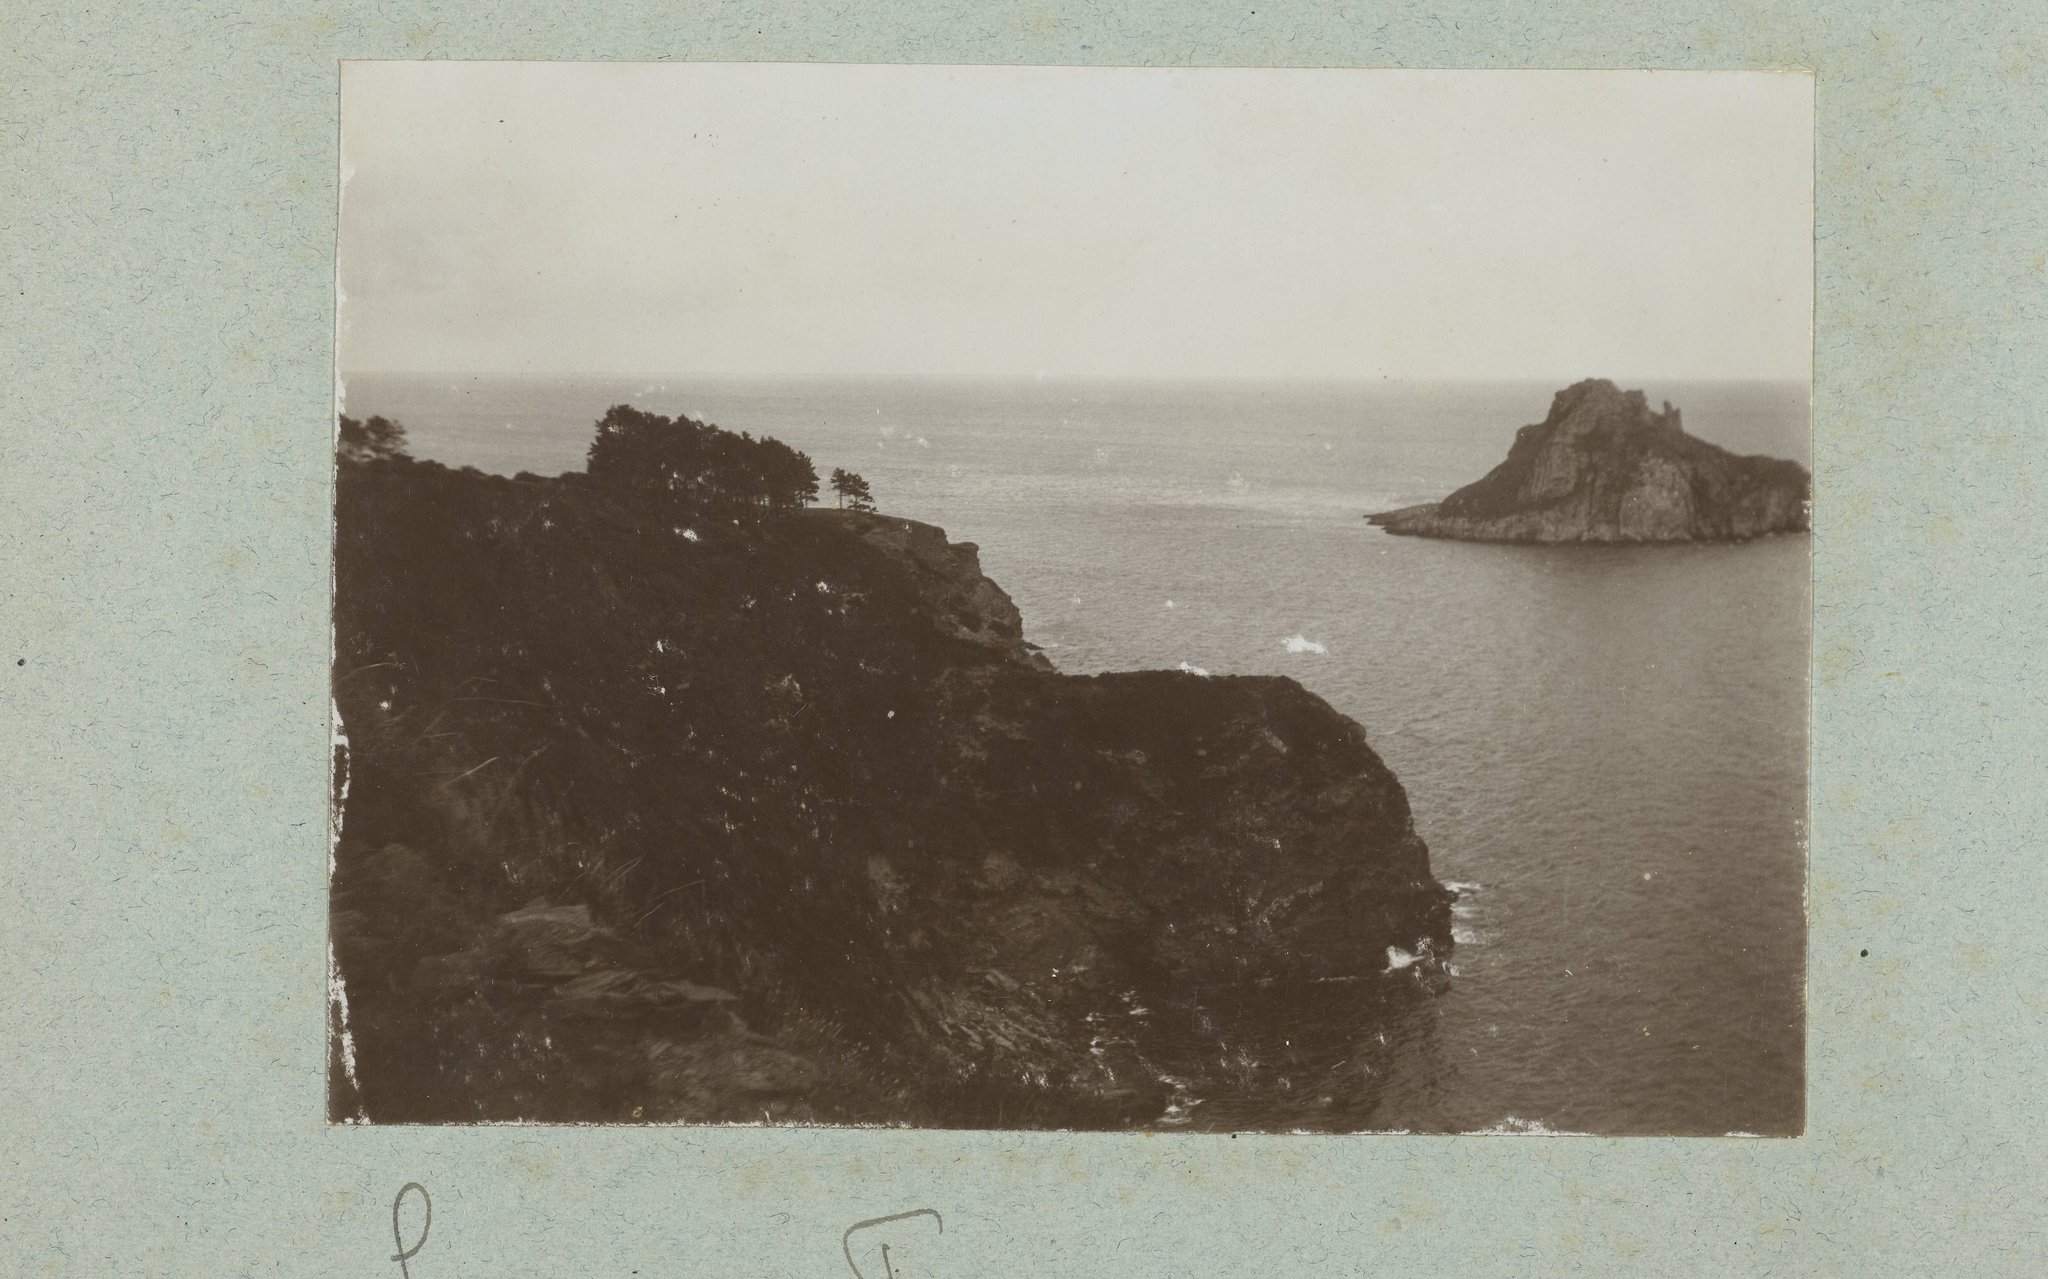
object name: photograph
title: Photographieën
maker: frits freerks fontein fz.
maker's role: fotograaf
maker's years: 1882-1928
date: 1901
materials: cardboard, paper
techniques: gelatin silver print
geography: england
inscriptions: caption: ‘Sea near Torquay’